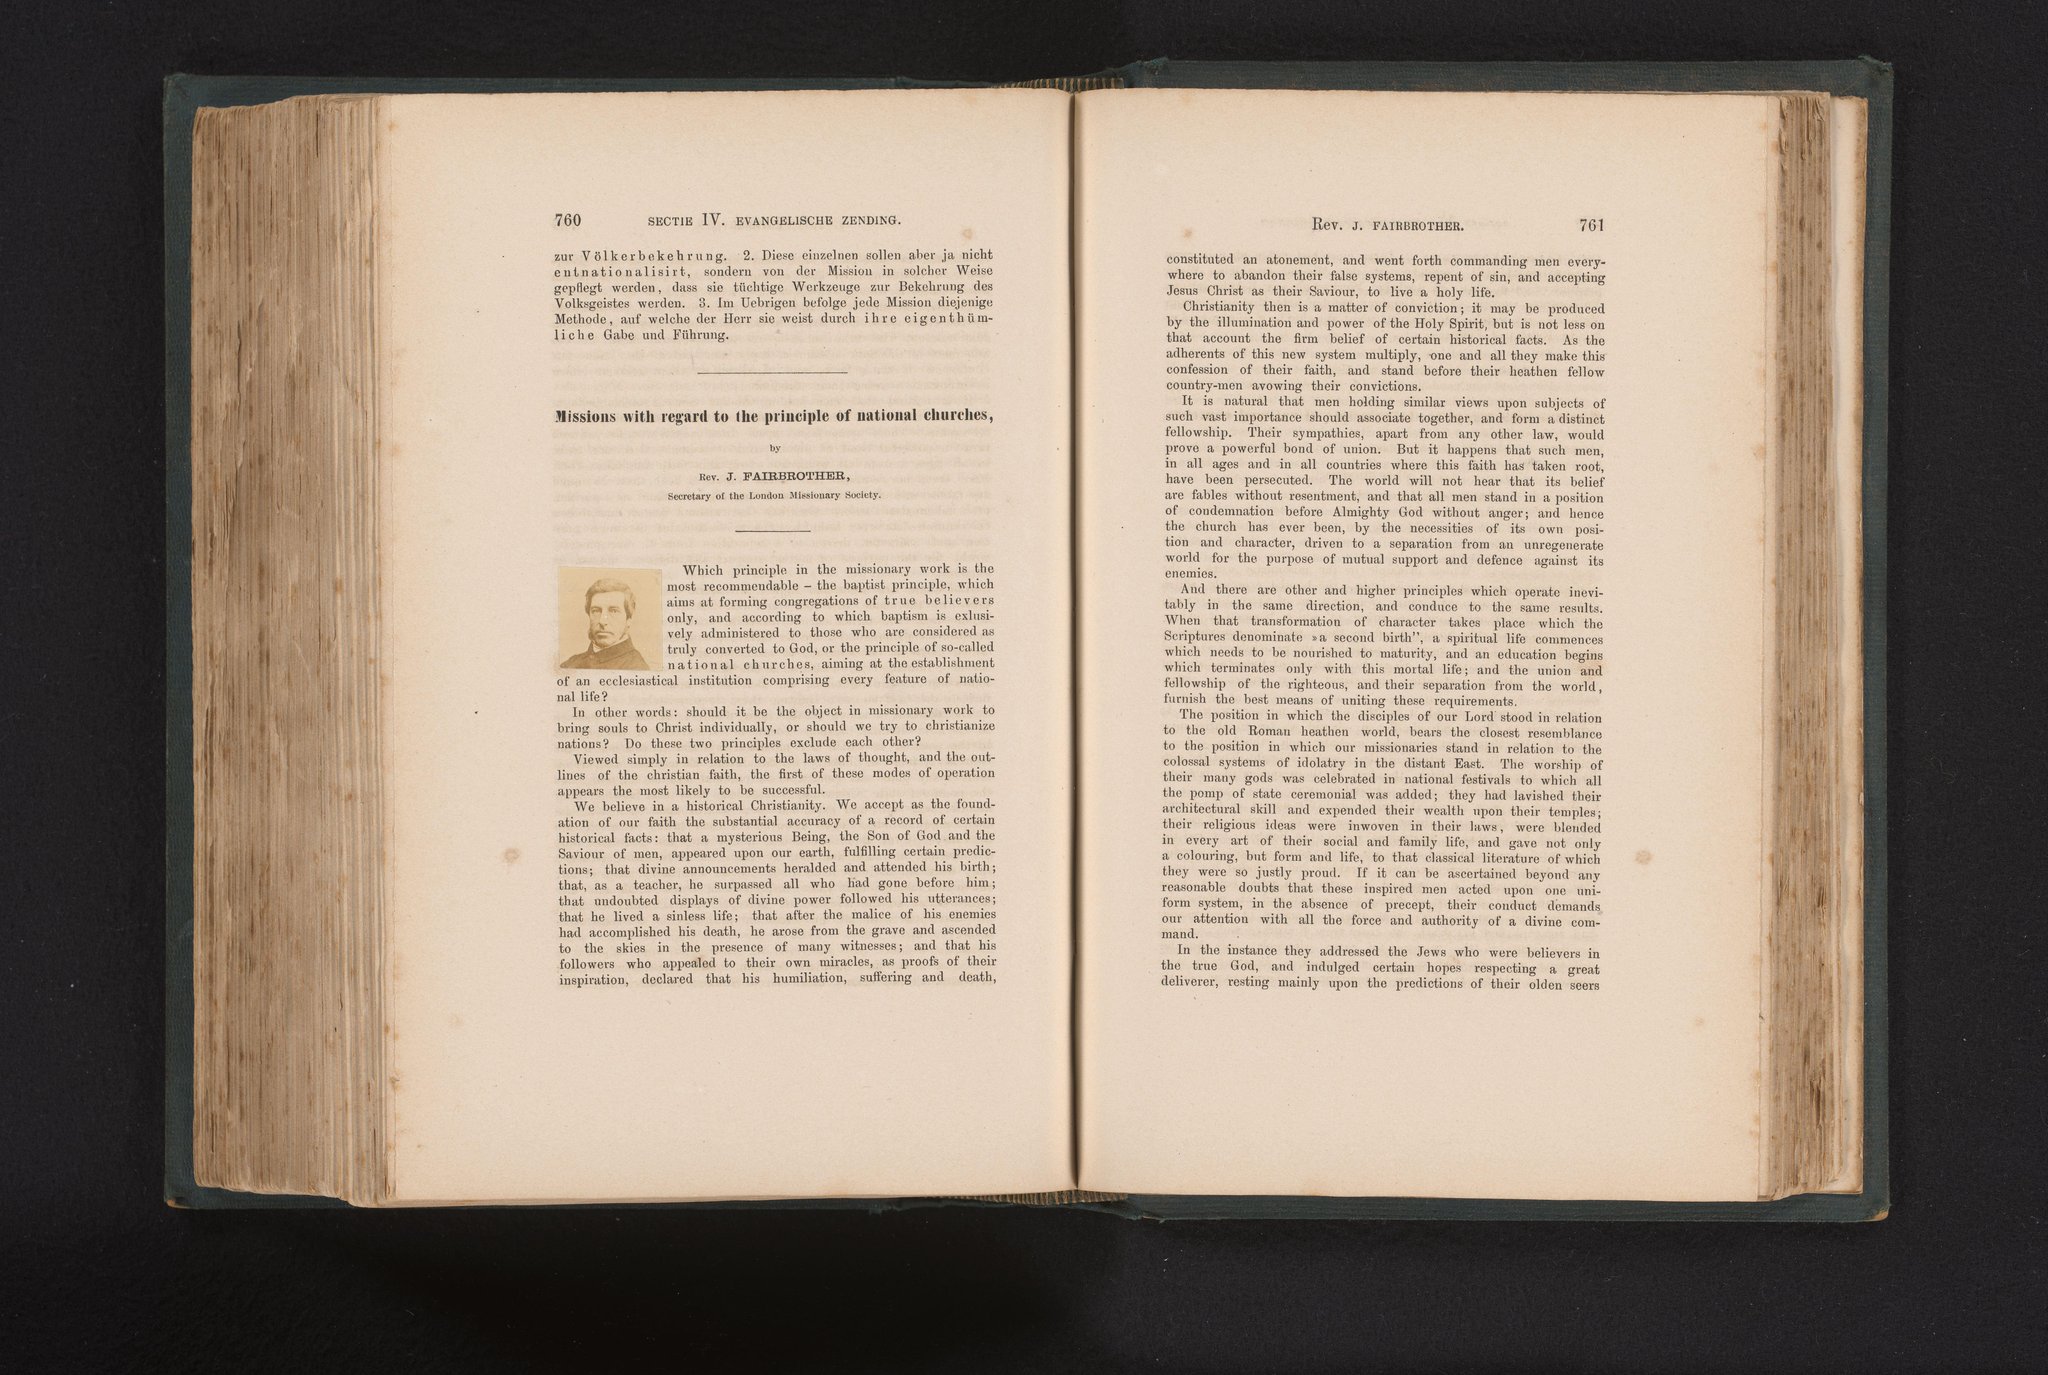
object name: photograph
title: Portret van dominee J. Fairbrother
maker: Anonymous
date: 1855-1867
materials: paper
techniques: albumen print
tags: adult man, historical persons